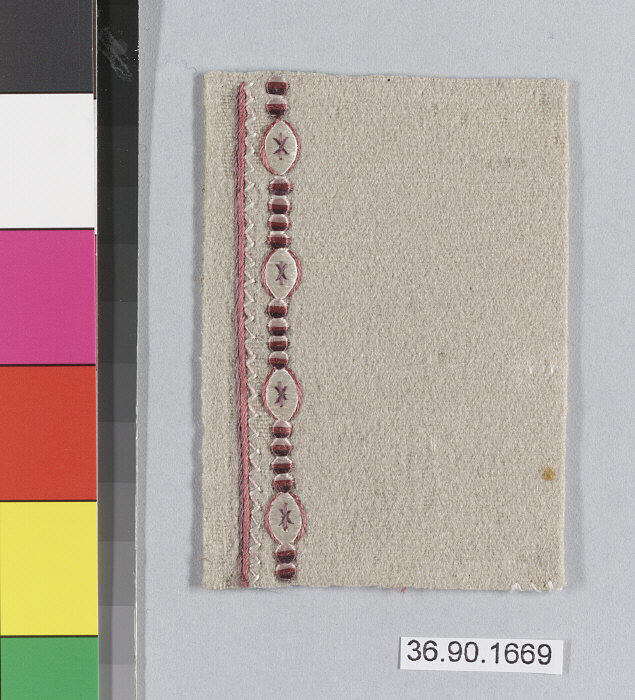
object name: sample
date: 1801-1833